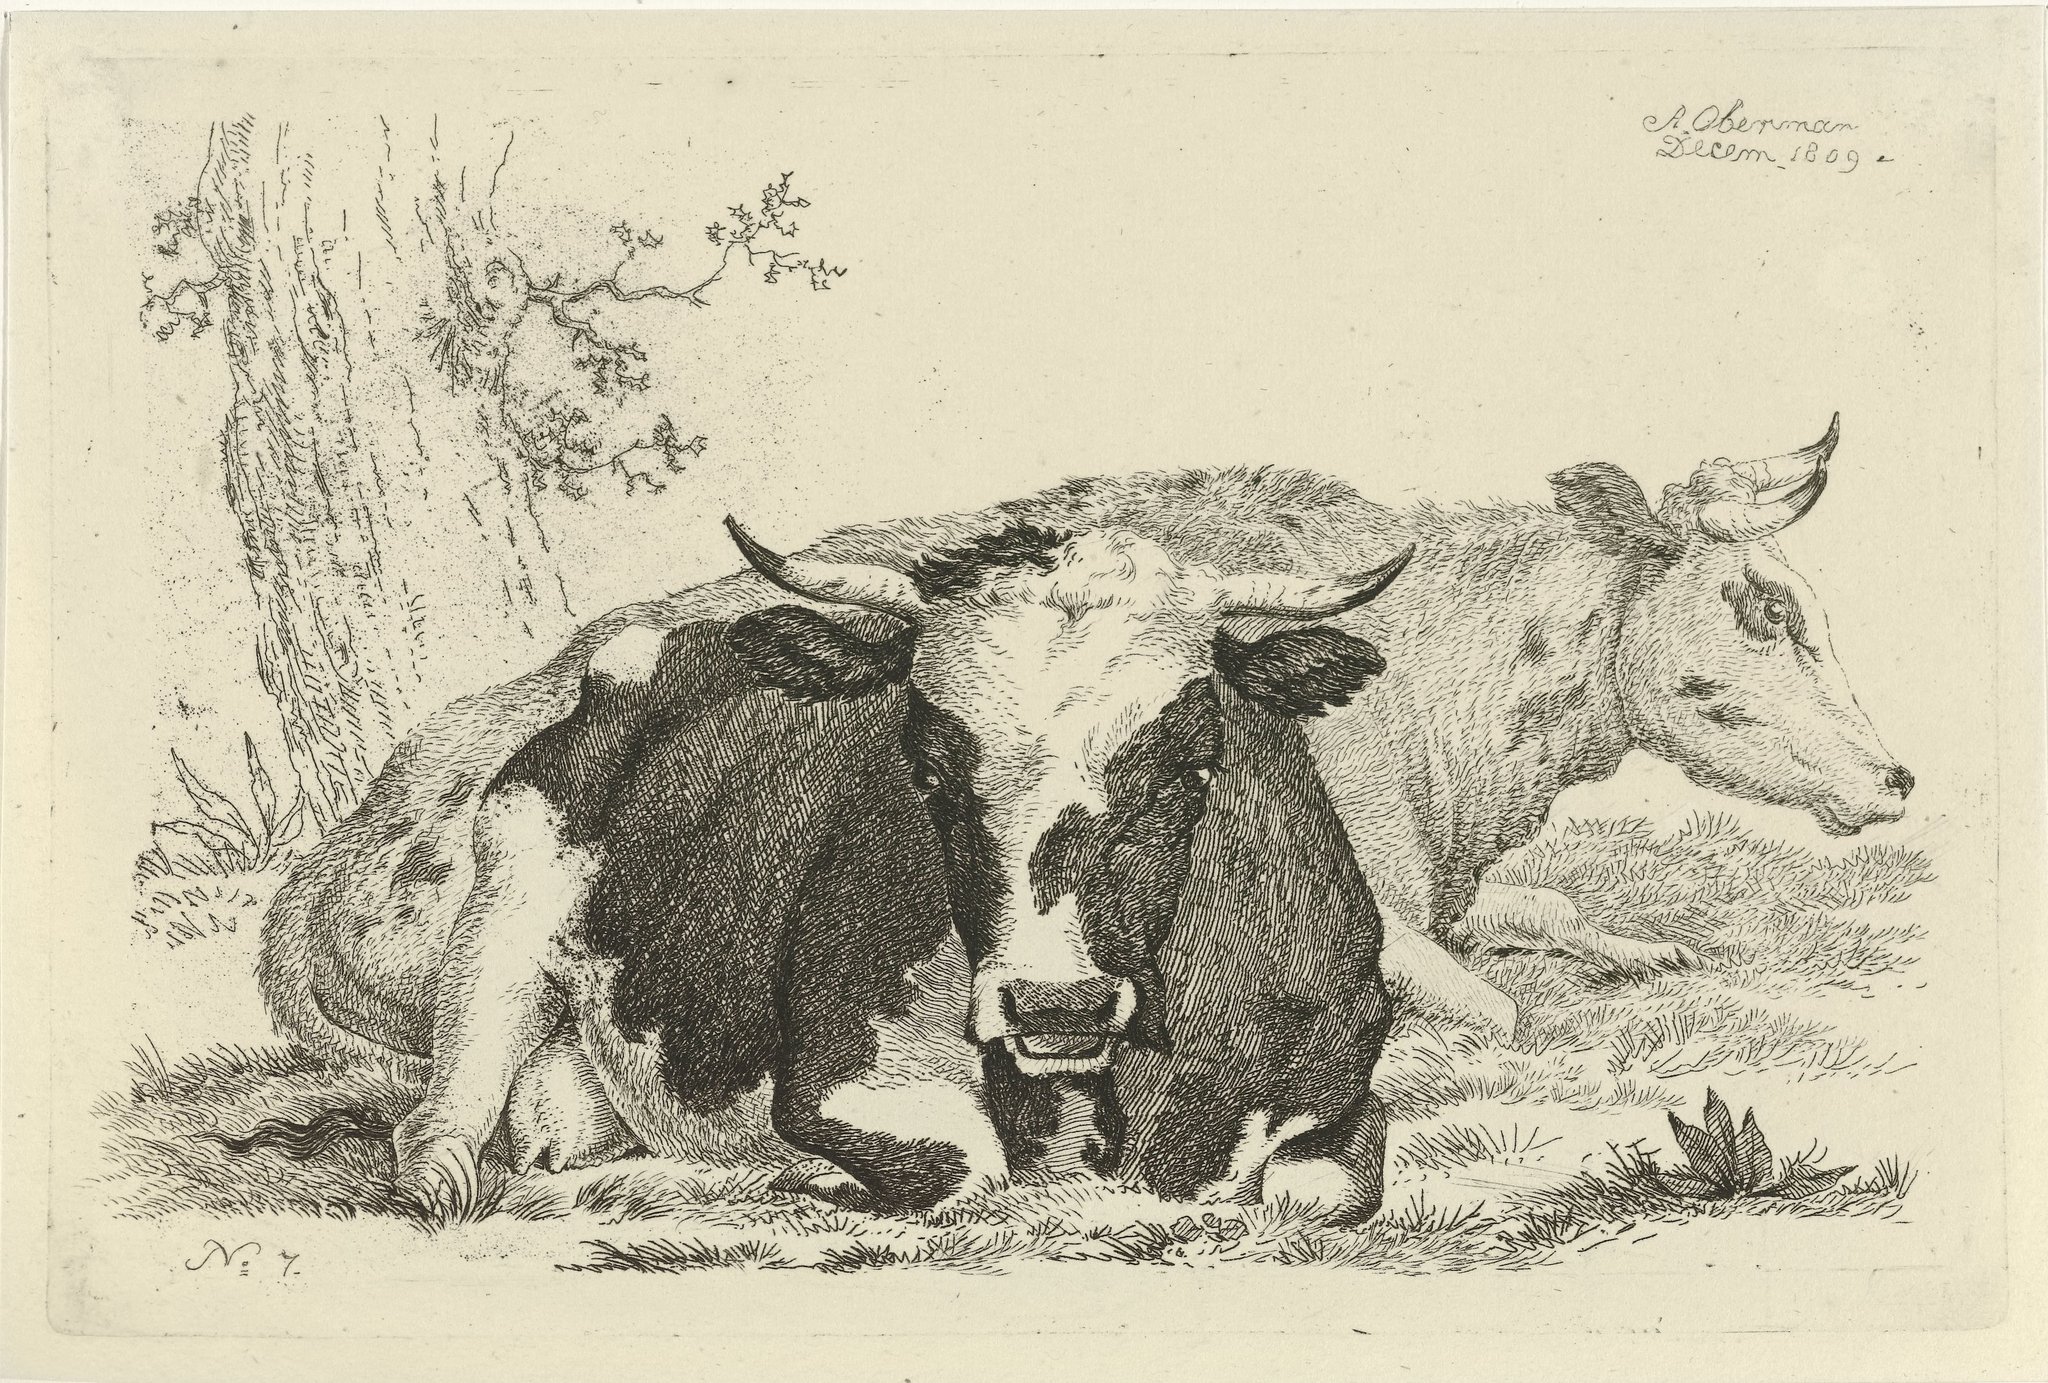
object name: print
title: Twee liggende koeien voor een boom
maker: anthony oberman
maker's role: draughtsman, painter, print maker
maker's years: 1781-1845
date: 1809-1812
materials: paper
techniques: etching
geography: amsterdam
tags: cattle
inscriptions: collector's mark: Lugt 2228